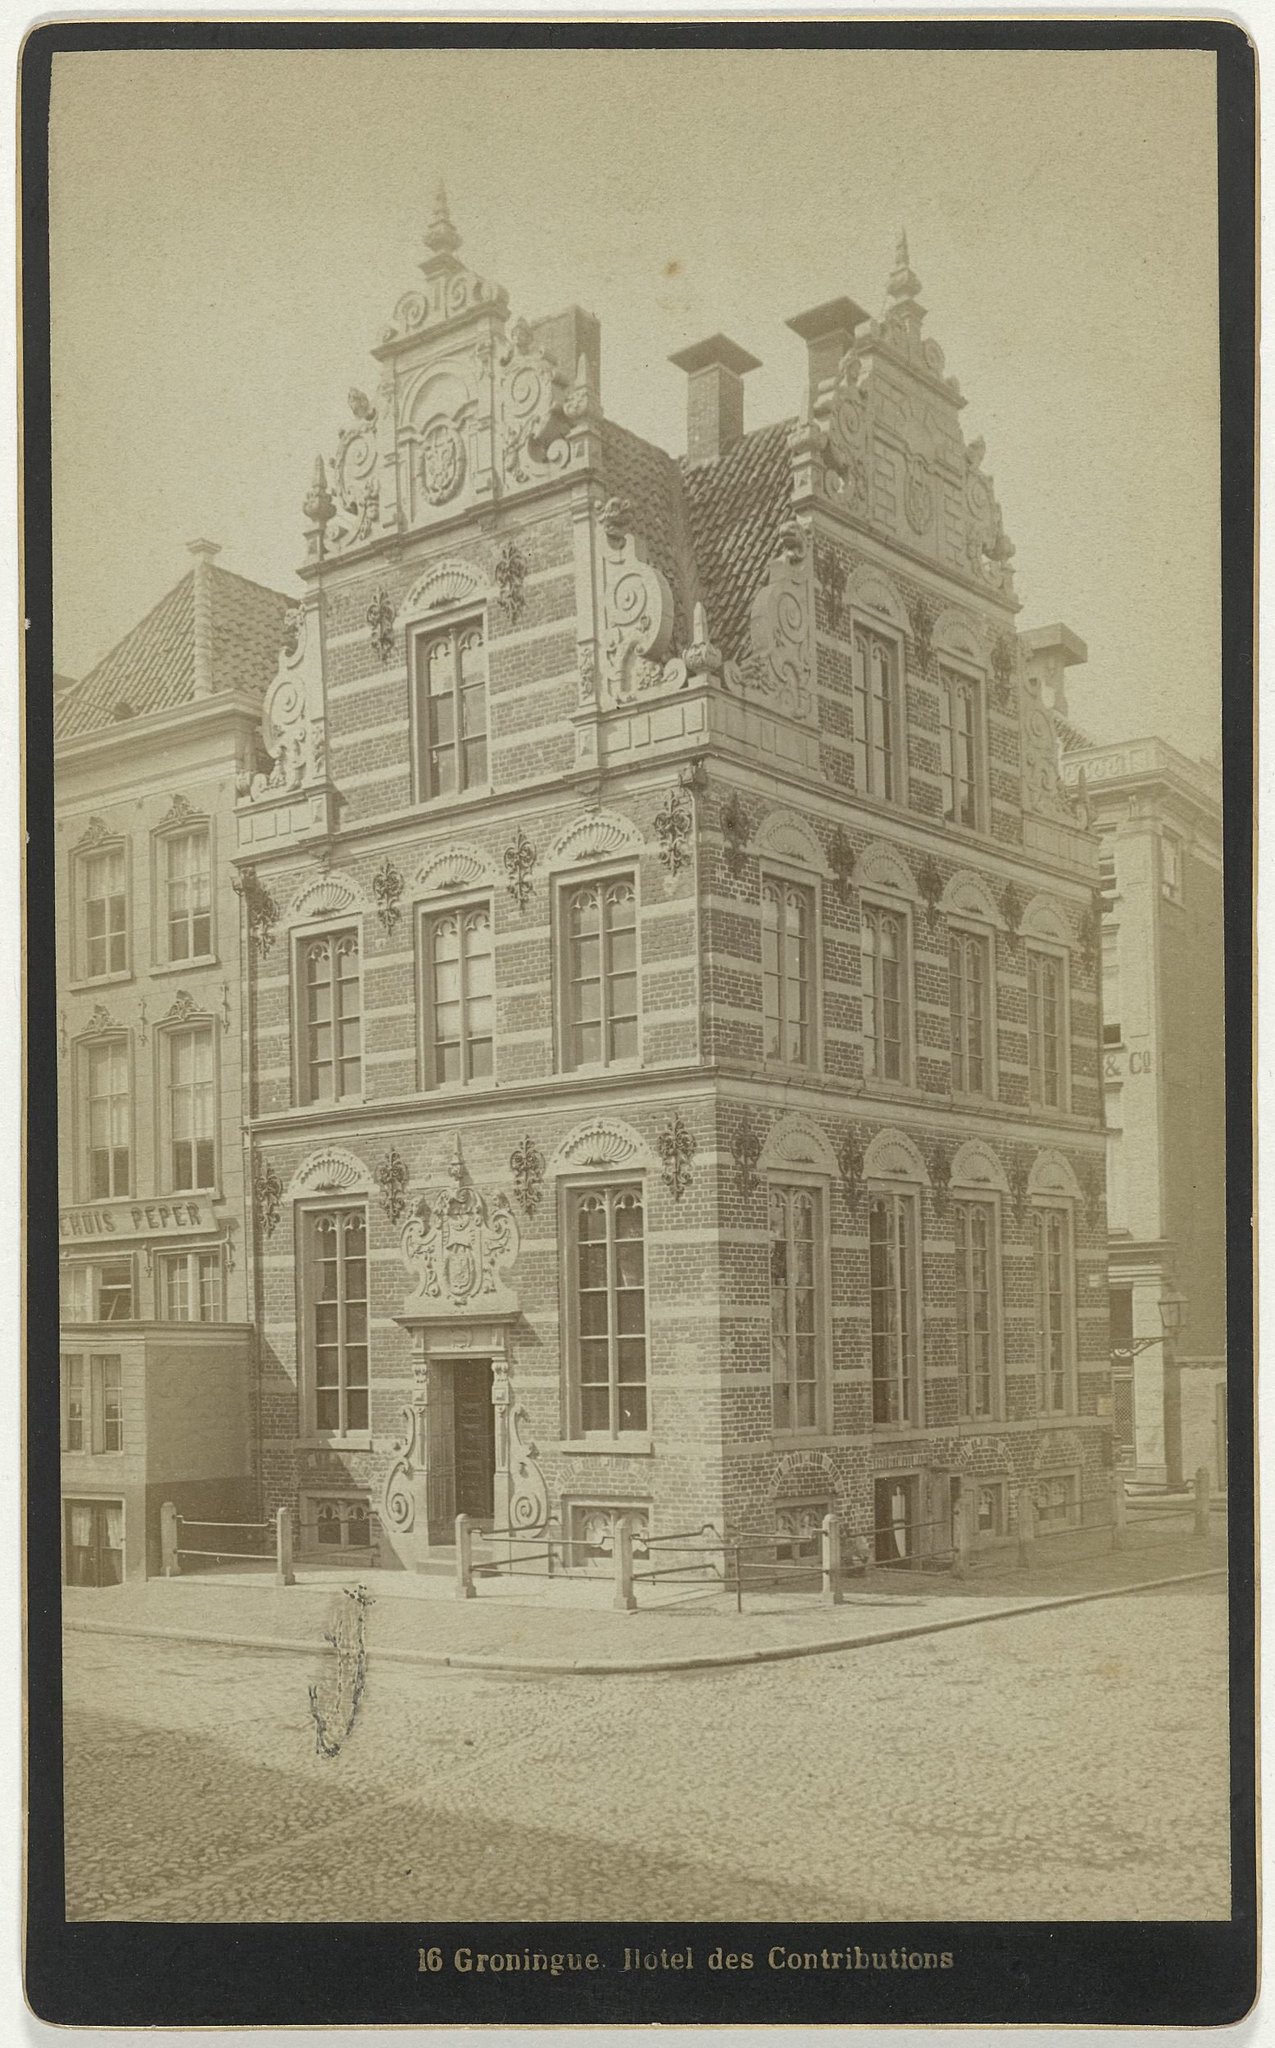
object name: cabinet photograph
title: Groningue, hotel des contributions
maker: Anonymous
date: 1887-1913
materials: cardboard, paper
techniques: albumen print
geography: groningen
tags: tax collection